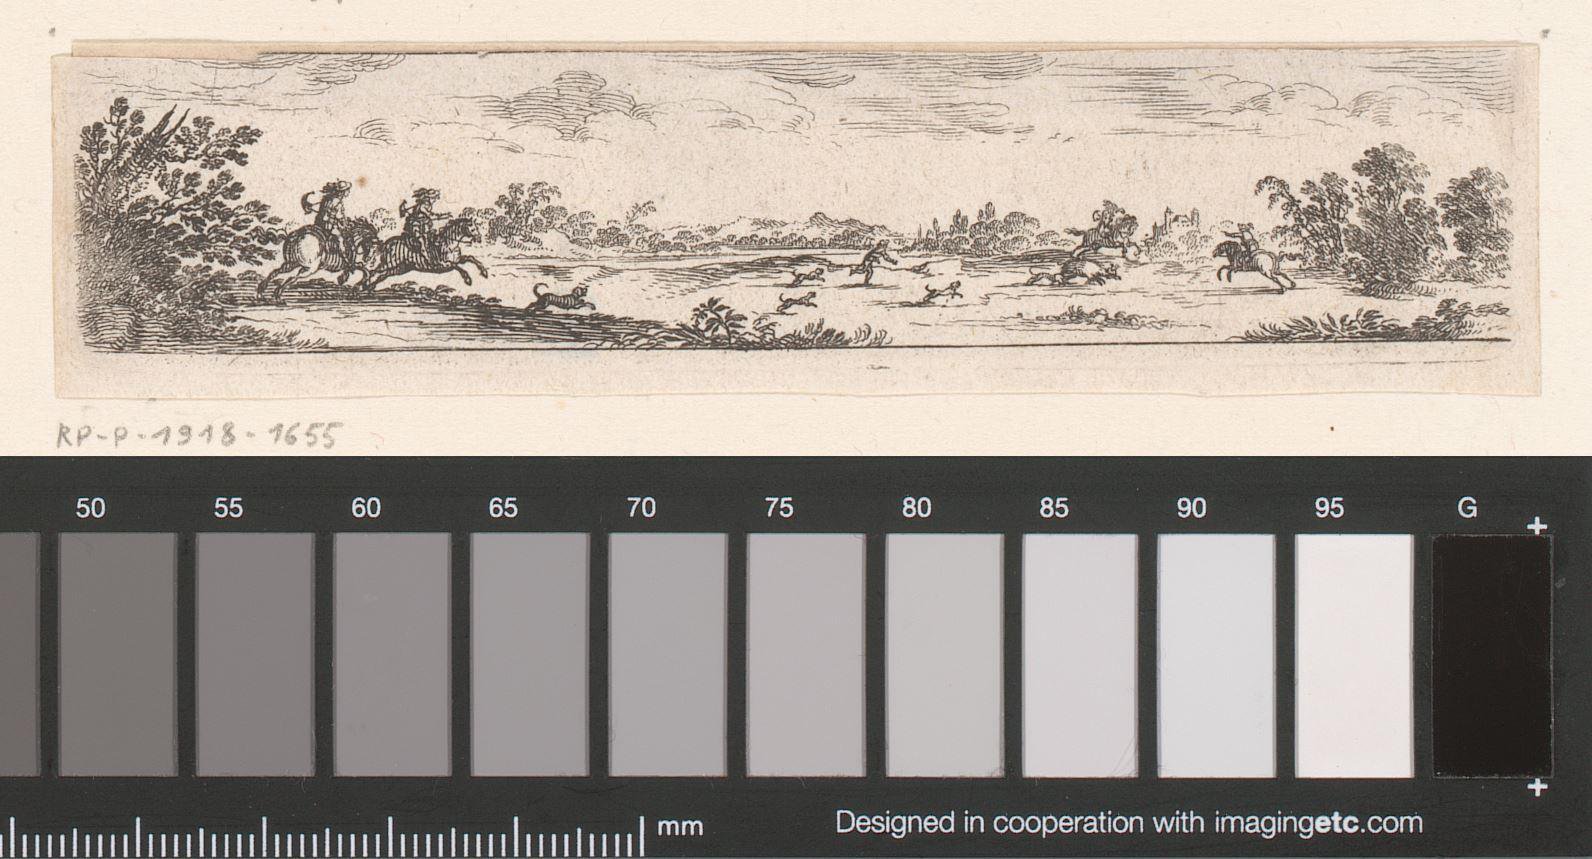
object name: print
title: Vignetten met buitentaferelen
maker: nicolas cochin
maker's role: print maker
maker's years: 1610-1686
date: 1620-1686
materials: paper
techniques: etching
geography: france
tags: landscapes, hunters hunting (n.b.: in 1988-1990 this notation denoted the concept of 43c11421 'hunters resting during the hunt')